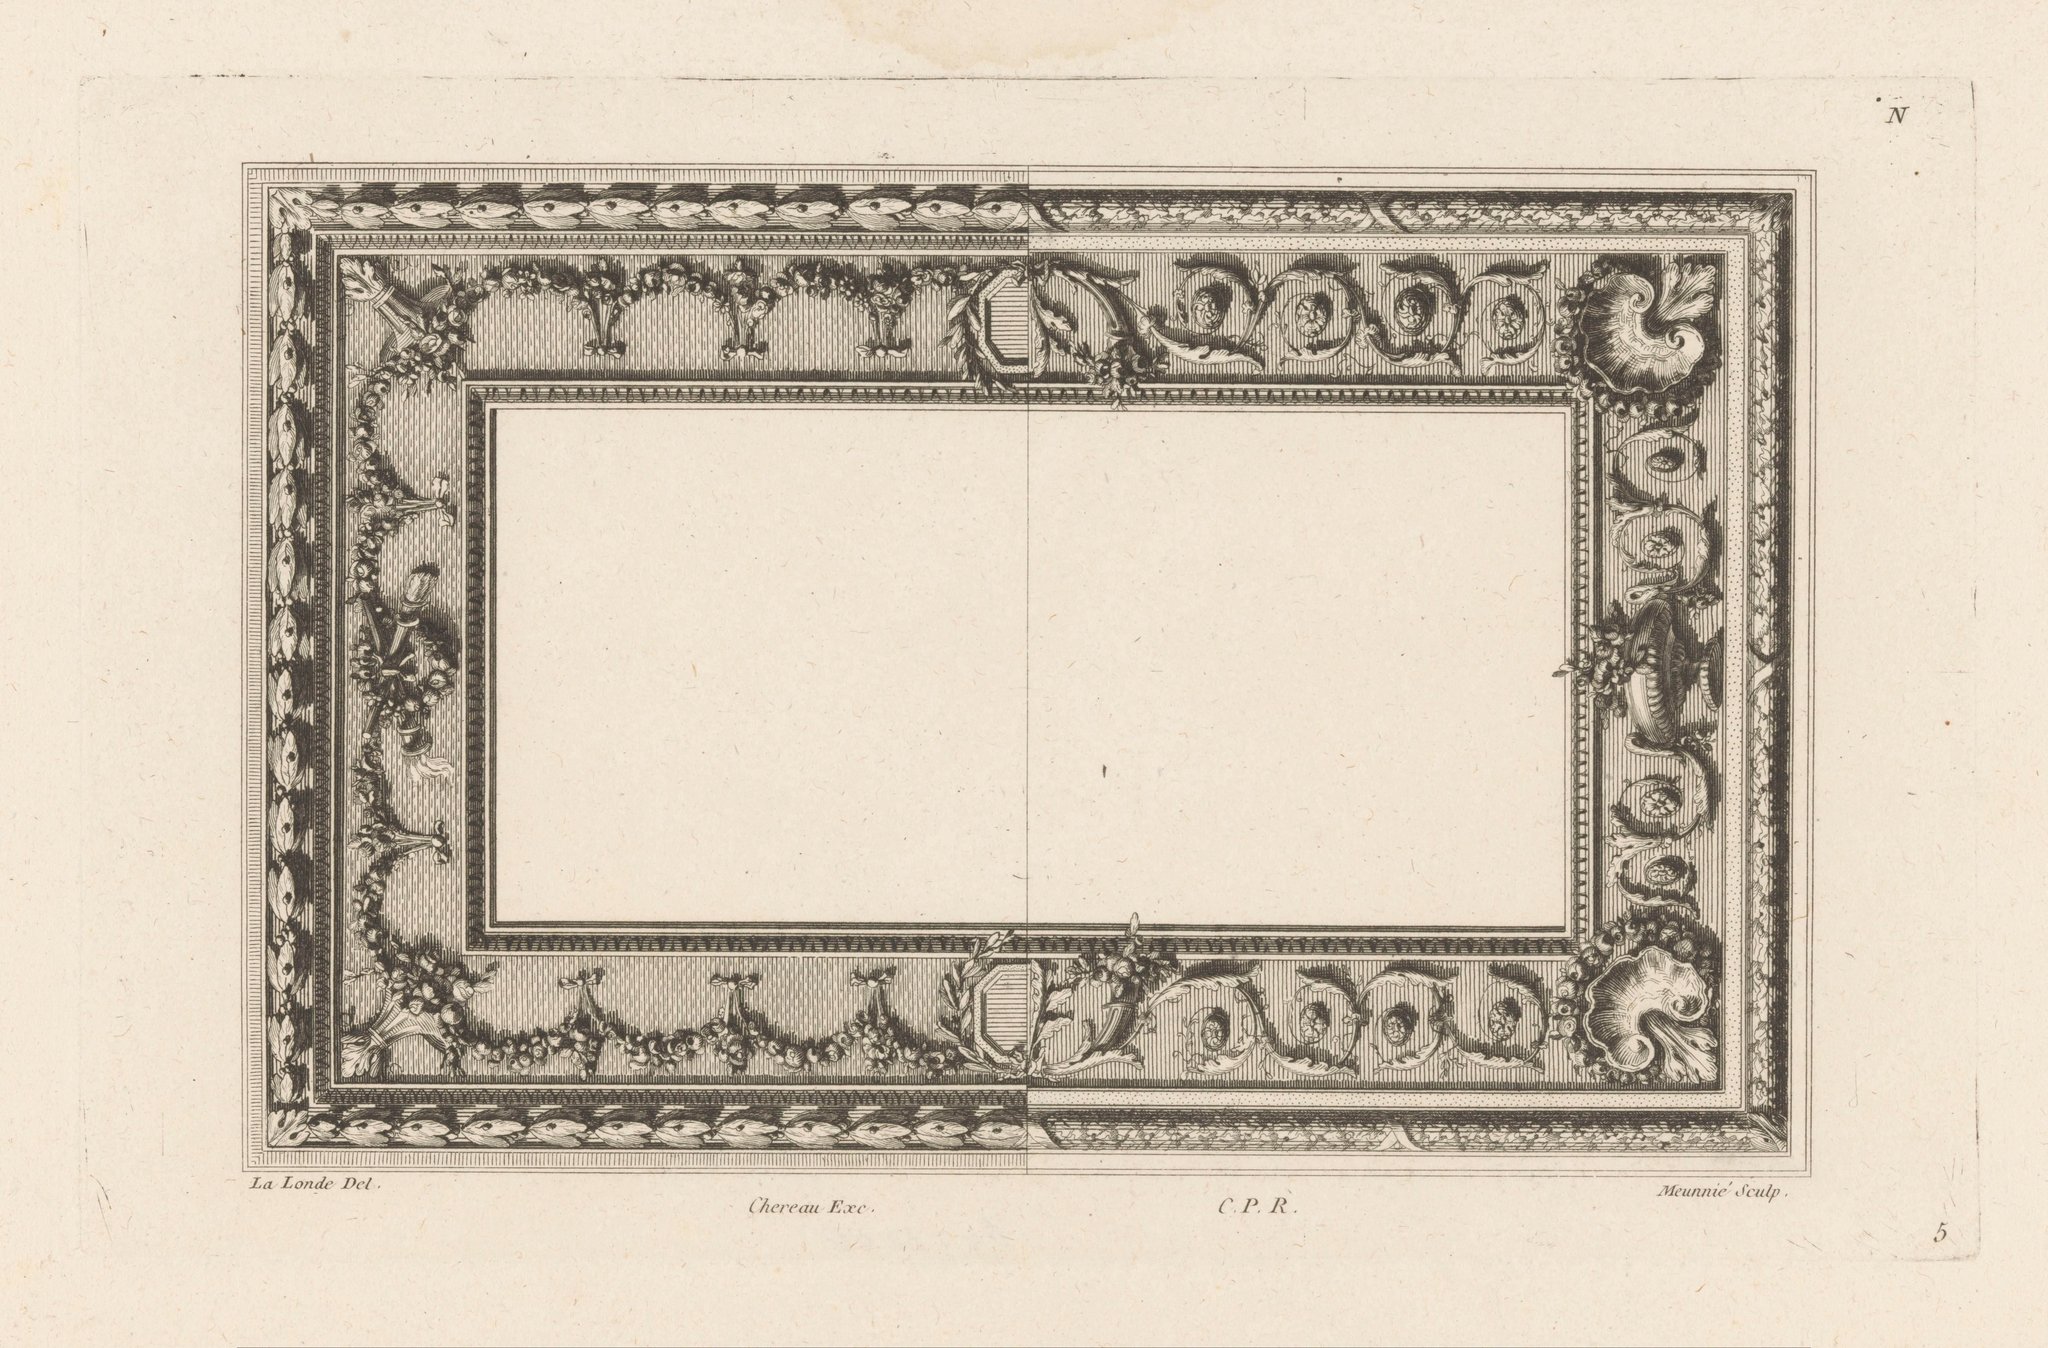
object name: print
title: Plafond met vlechtwerk en guirlandes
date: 1784-1785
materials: paper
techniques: engraving, etching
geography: paris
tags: interlace ~ ornament, (decorated) ceiling, ornament ~ festoon, garland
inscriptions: collector's mark: Lugt 2228, collector's mark: Lugt 2760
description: Een rechthoekig geornamenteerd plafond met een rand met guirlandes, vlechtwerk, hoornen des overvloeds en schelpmotieven. Daaromheen een tweede rand met bladmotieven.